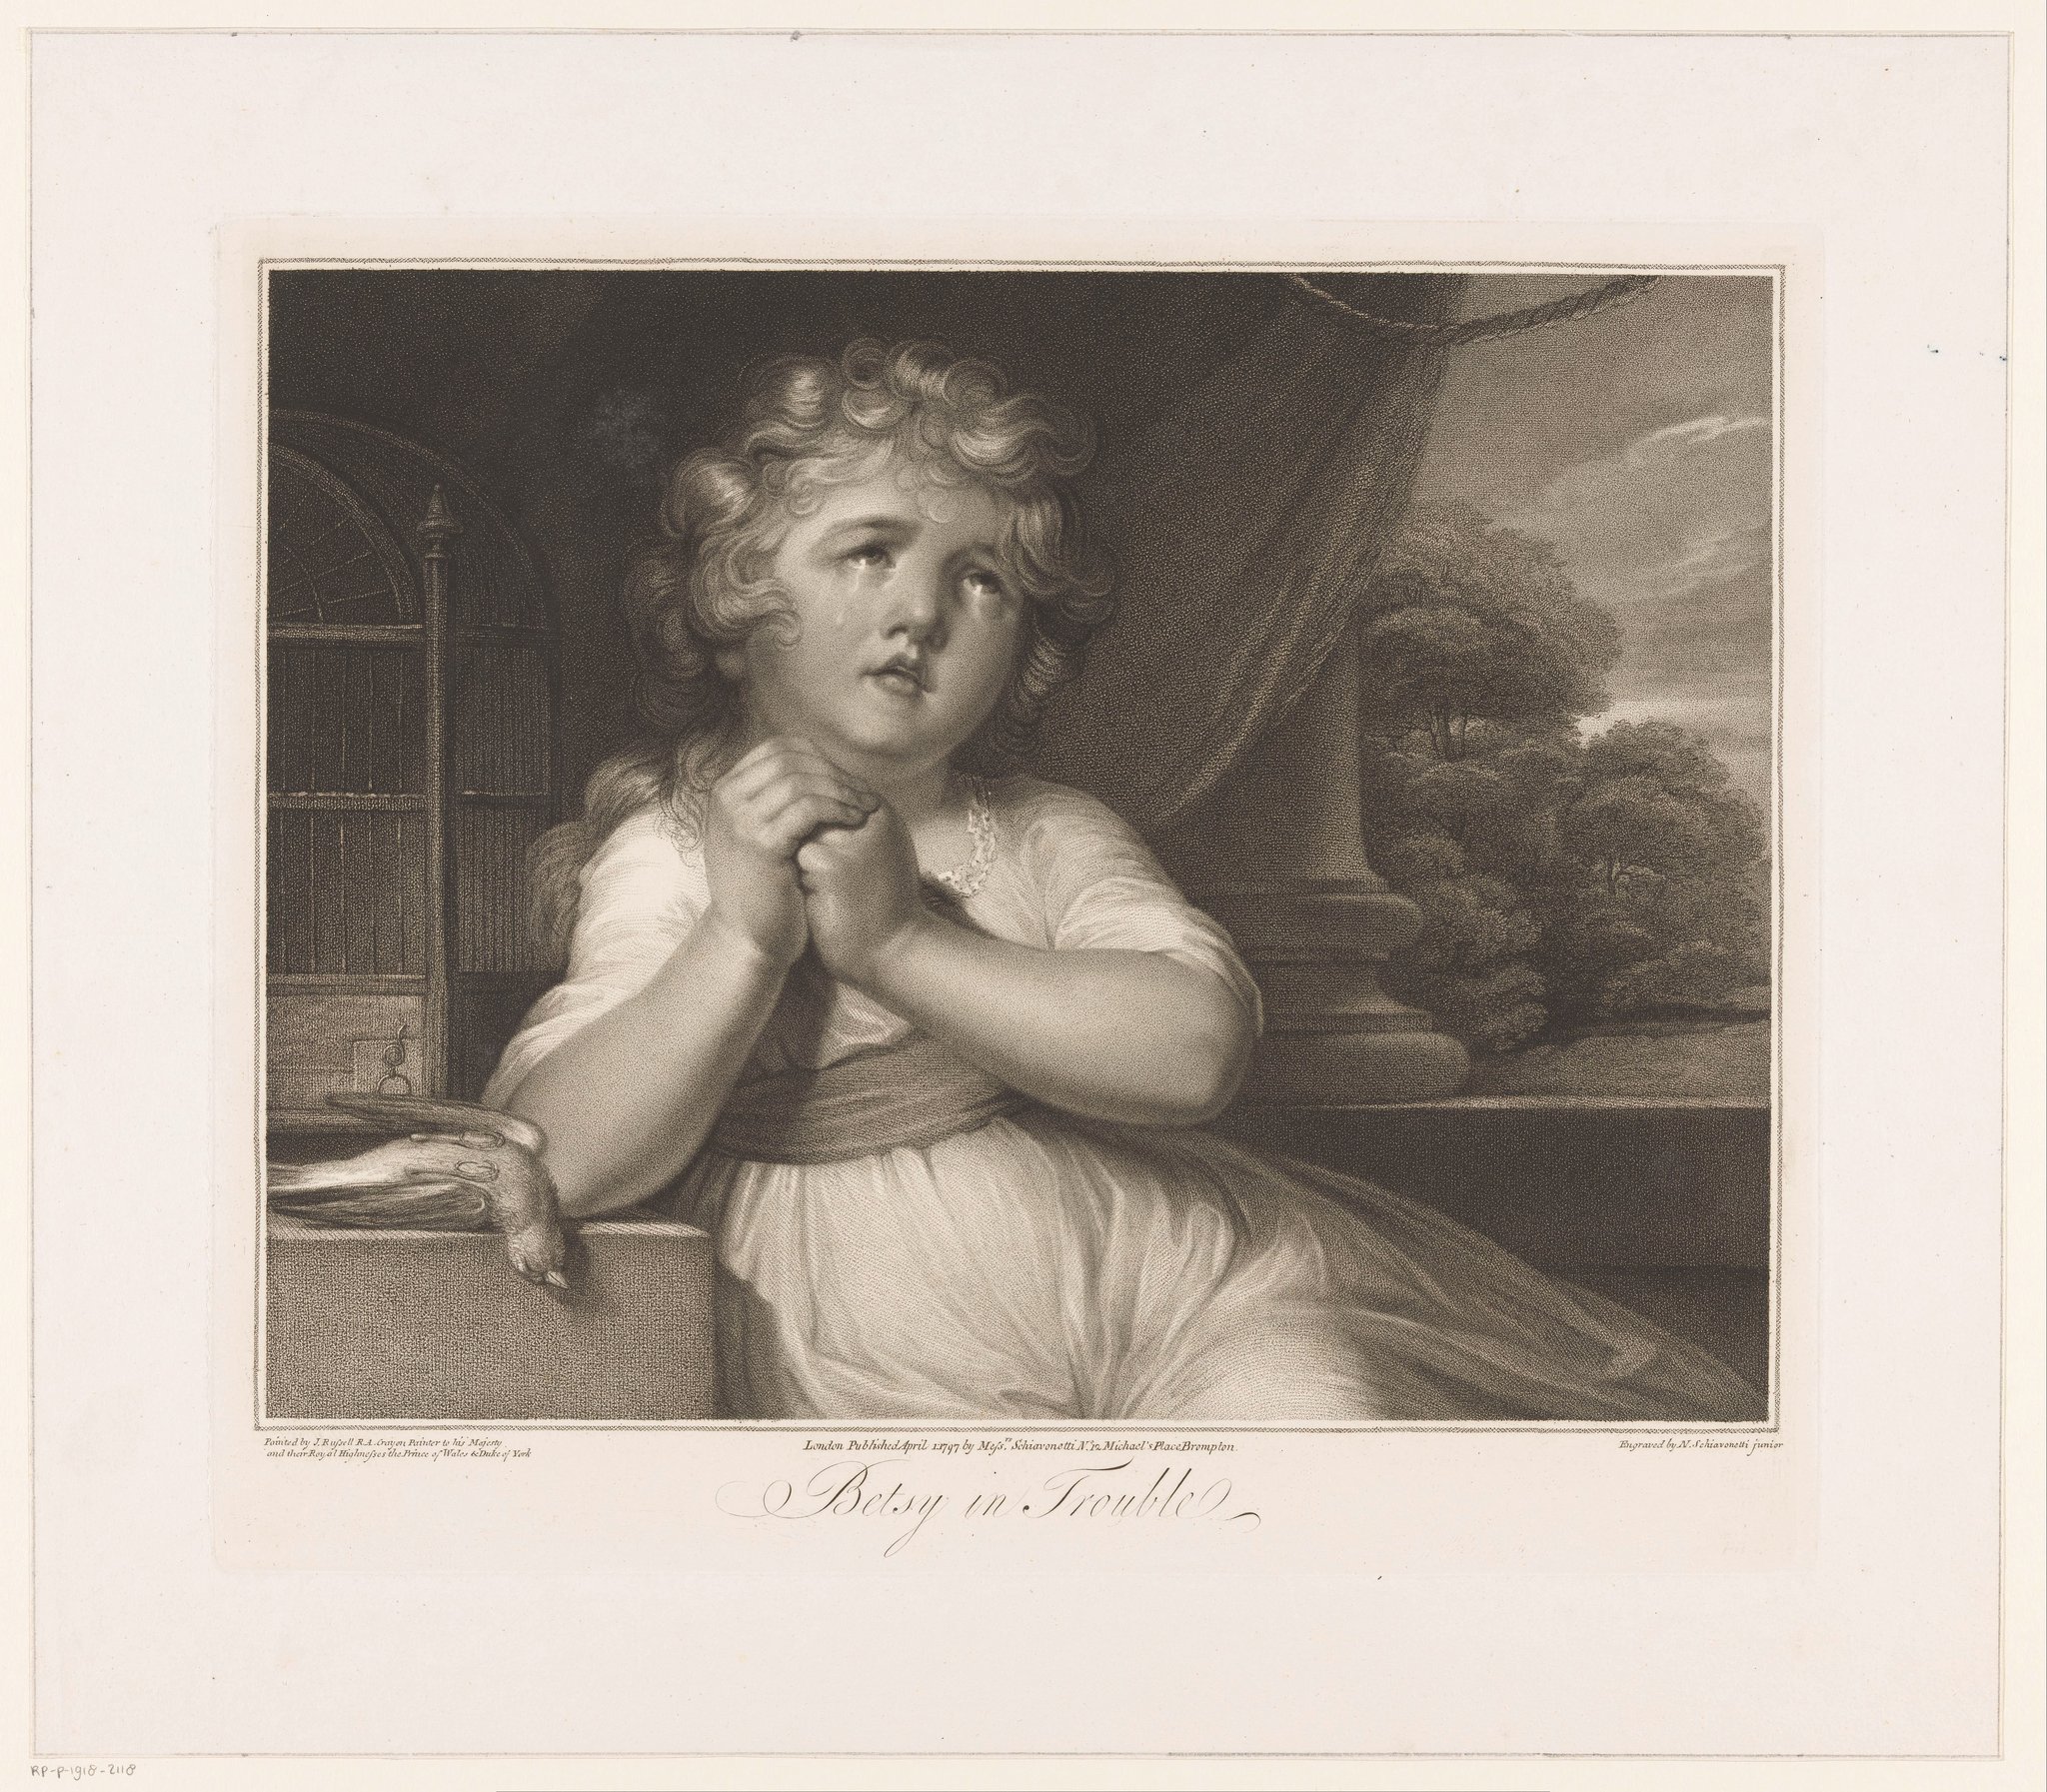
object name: print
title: Betsy in Trouble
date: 1797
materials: paper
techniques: engraving, etching, roulette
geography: london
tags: empty bird cage, birds, weeping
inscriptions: collector's mark: Lugt 2233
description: Een jong meisje, wenend en haar blik omhoog gericht. Links een dode vogel en een lege vogelkooi.